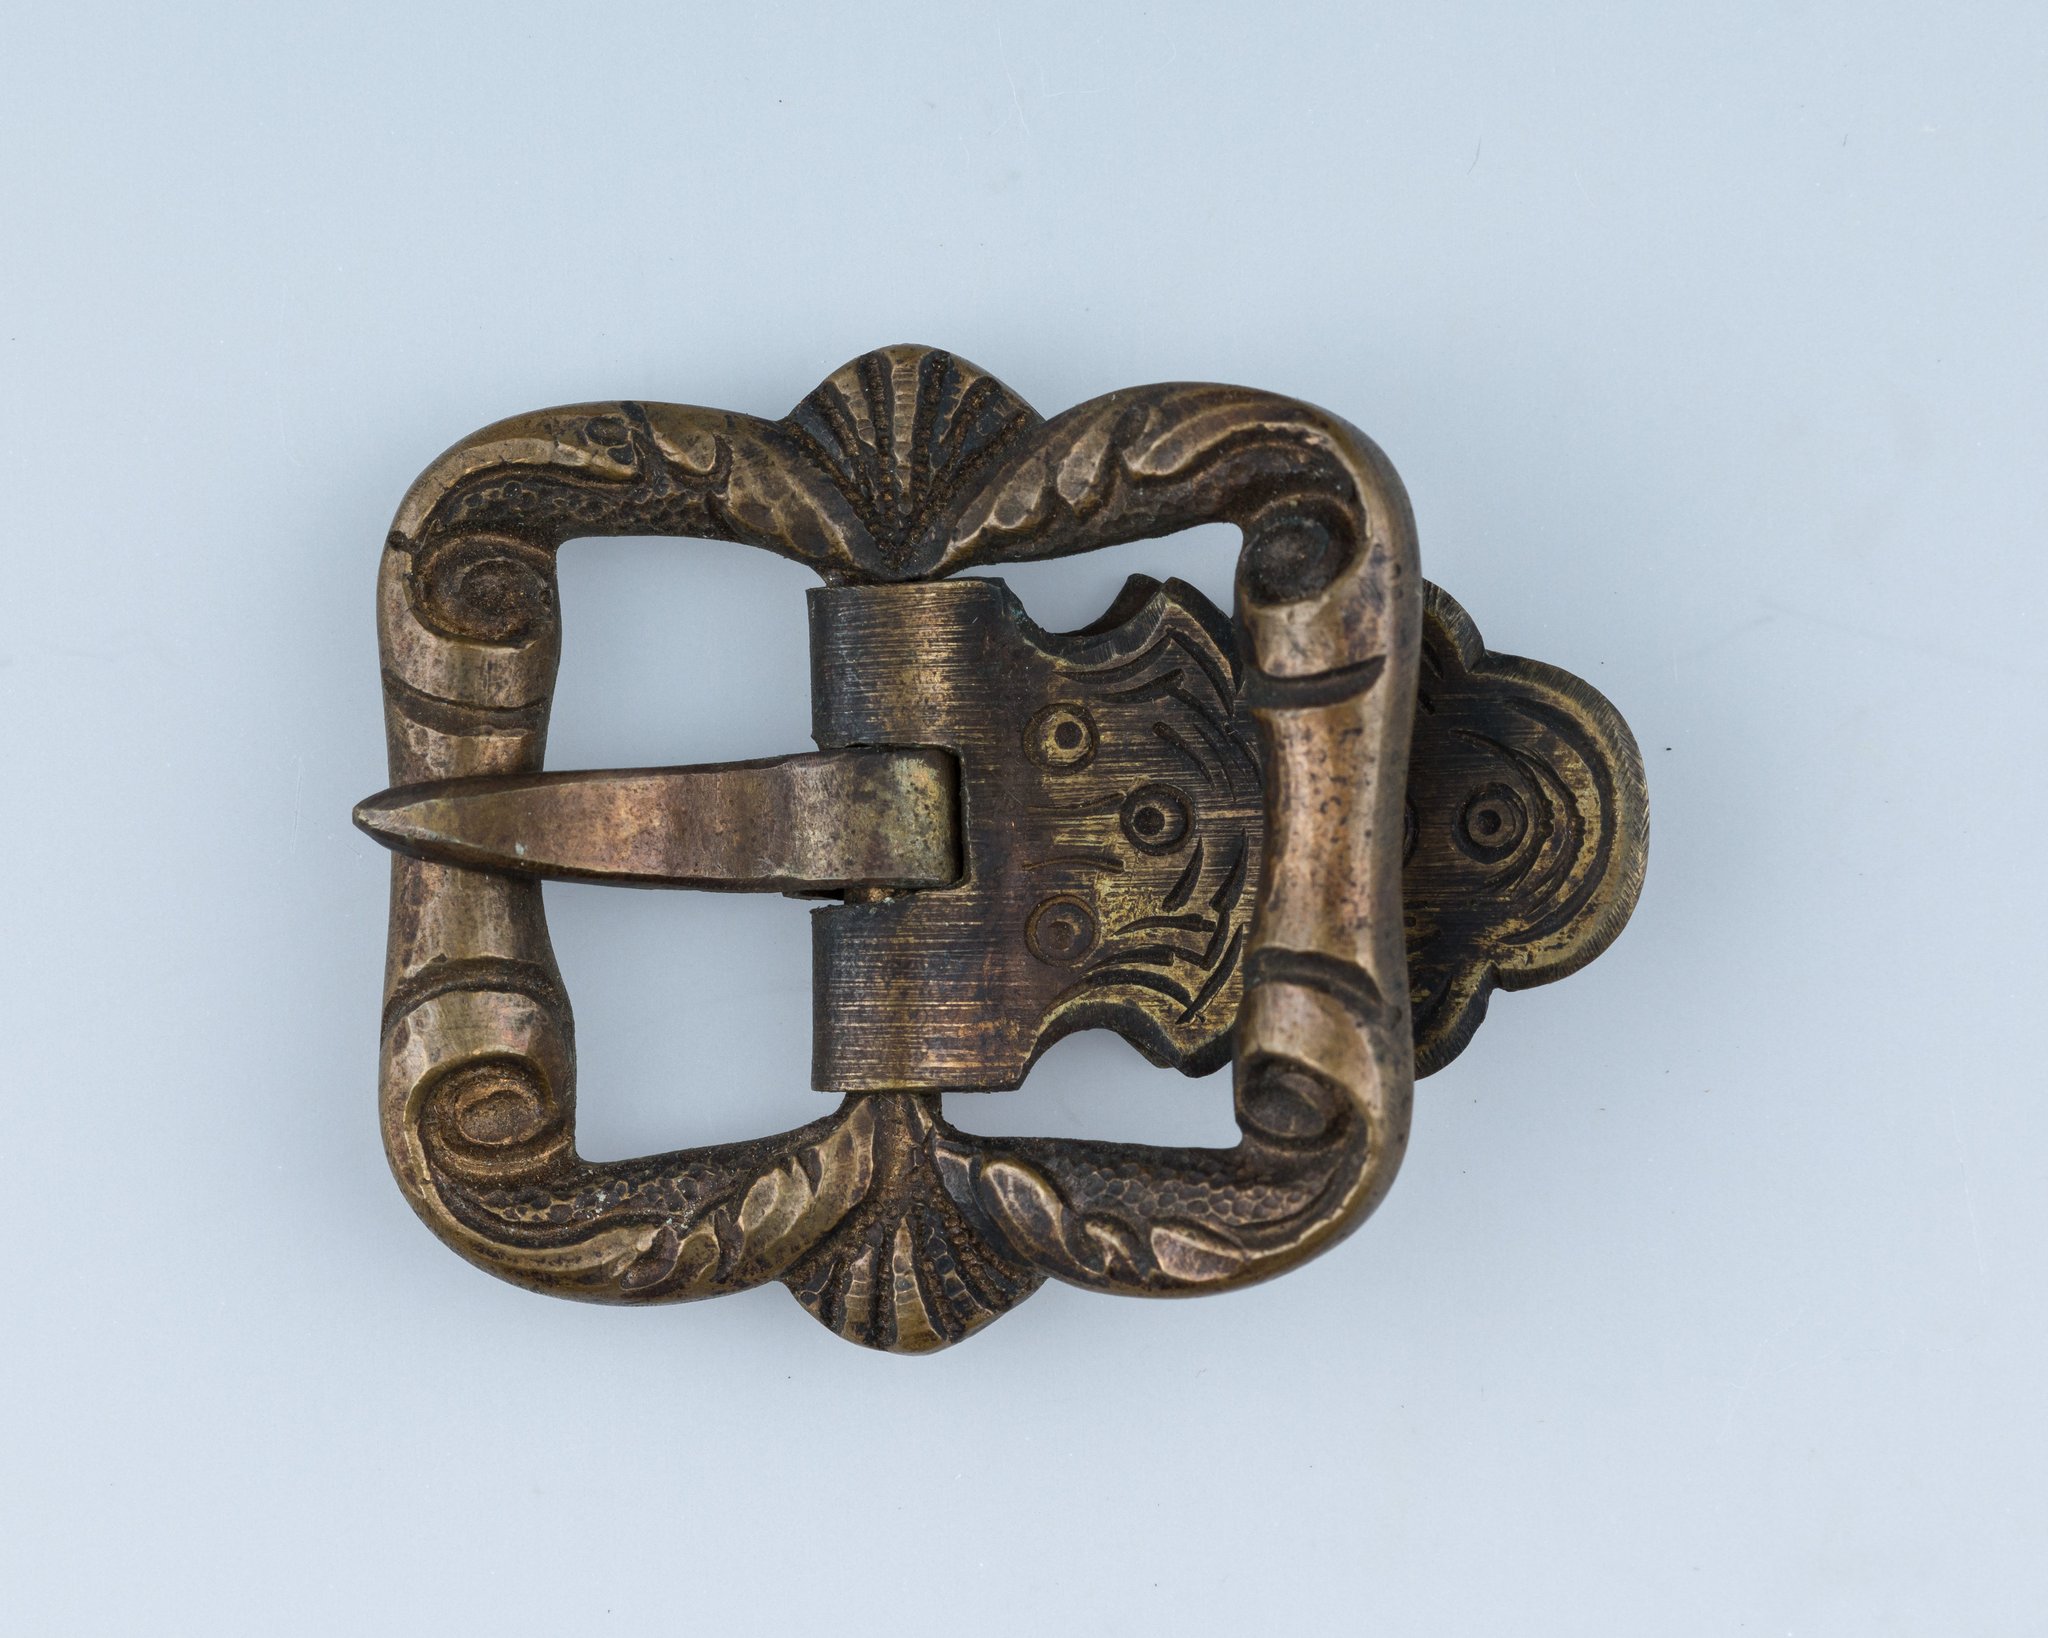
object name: buckle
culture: german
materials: brass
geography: germany